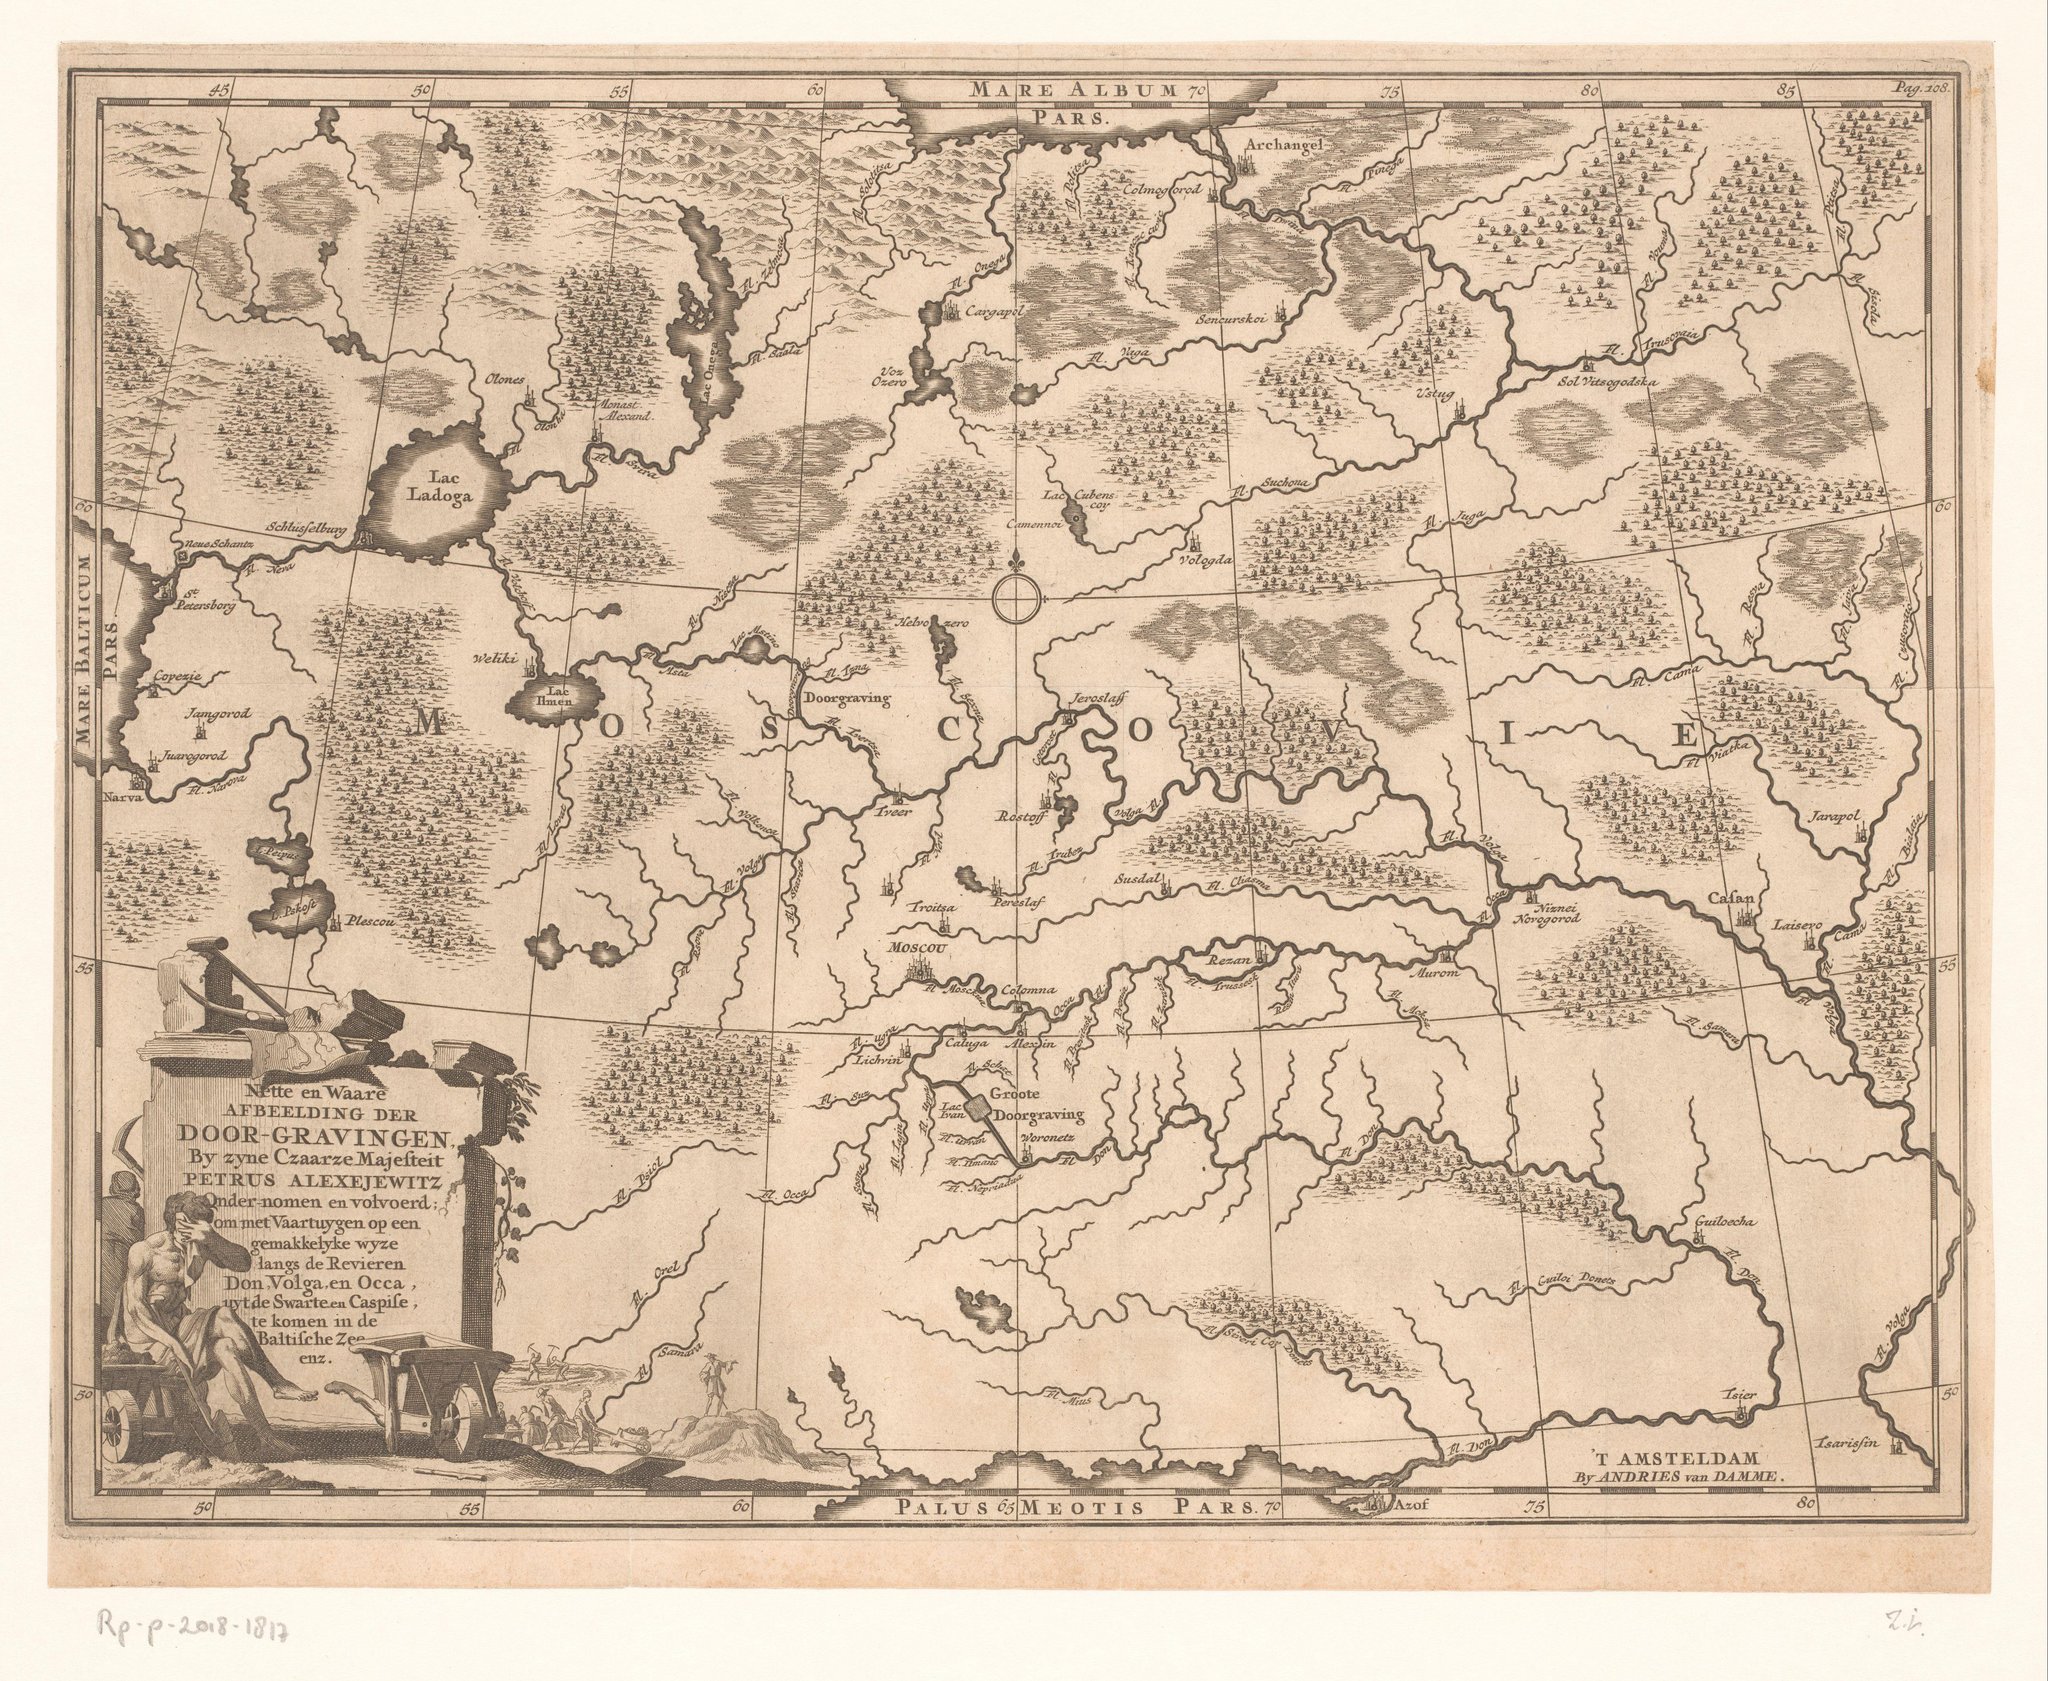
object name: map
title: Nette en waare afbeelding der door-gravingen by yne czaare majesteit Petrus Alexejewitz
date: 1702-1727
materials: paper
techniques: engraving, etching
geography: amsterdam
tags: peter i de grote (tsaar van rusland), construction of canal, maps of separate countries or regions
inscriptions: collector's mark: Lugt 2228